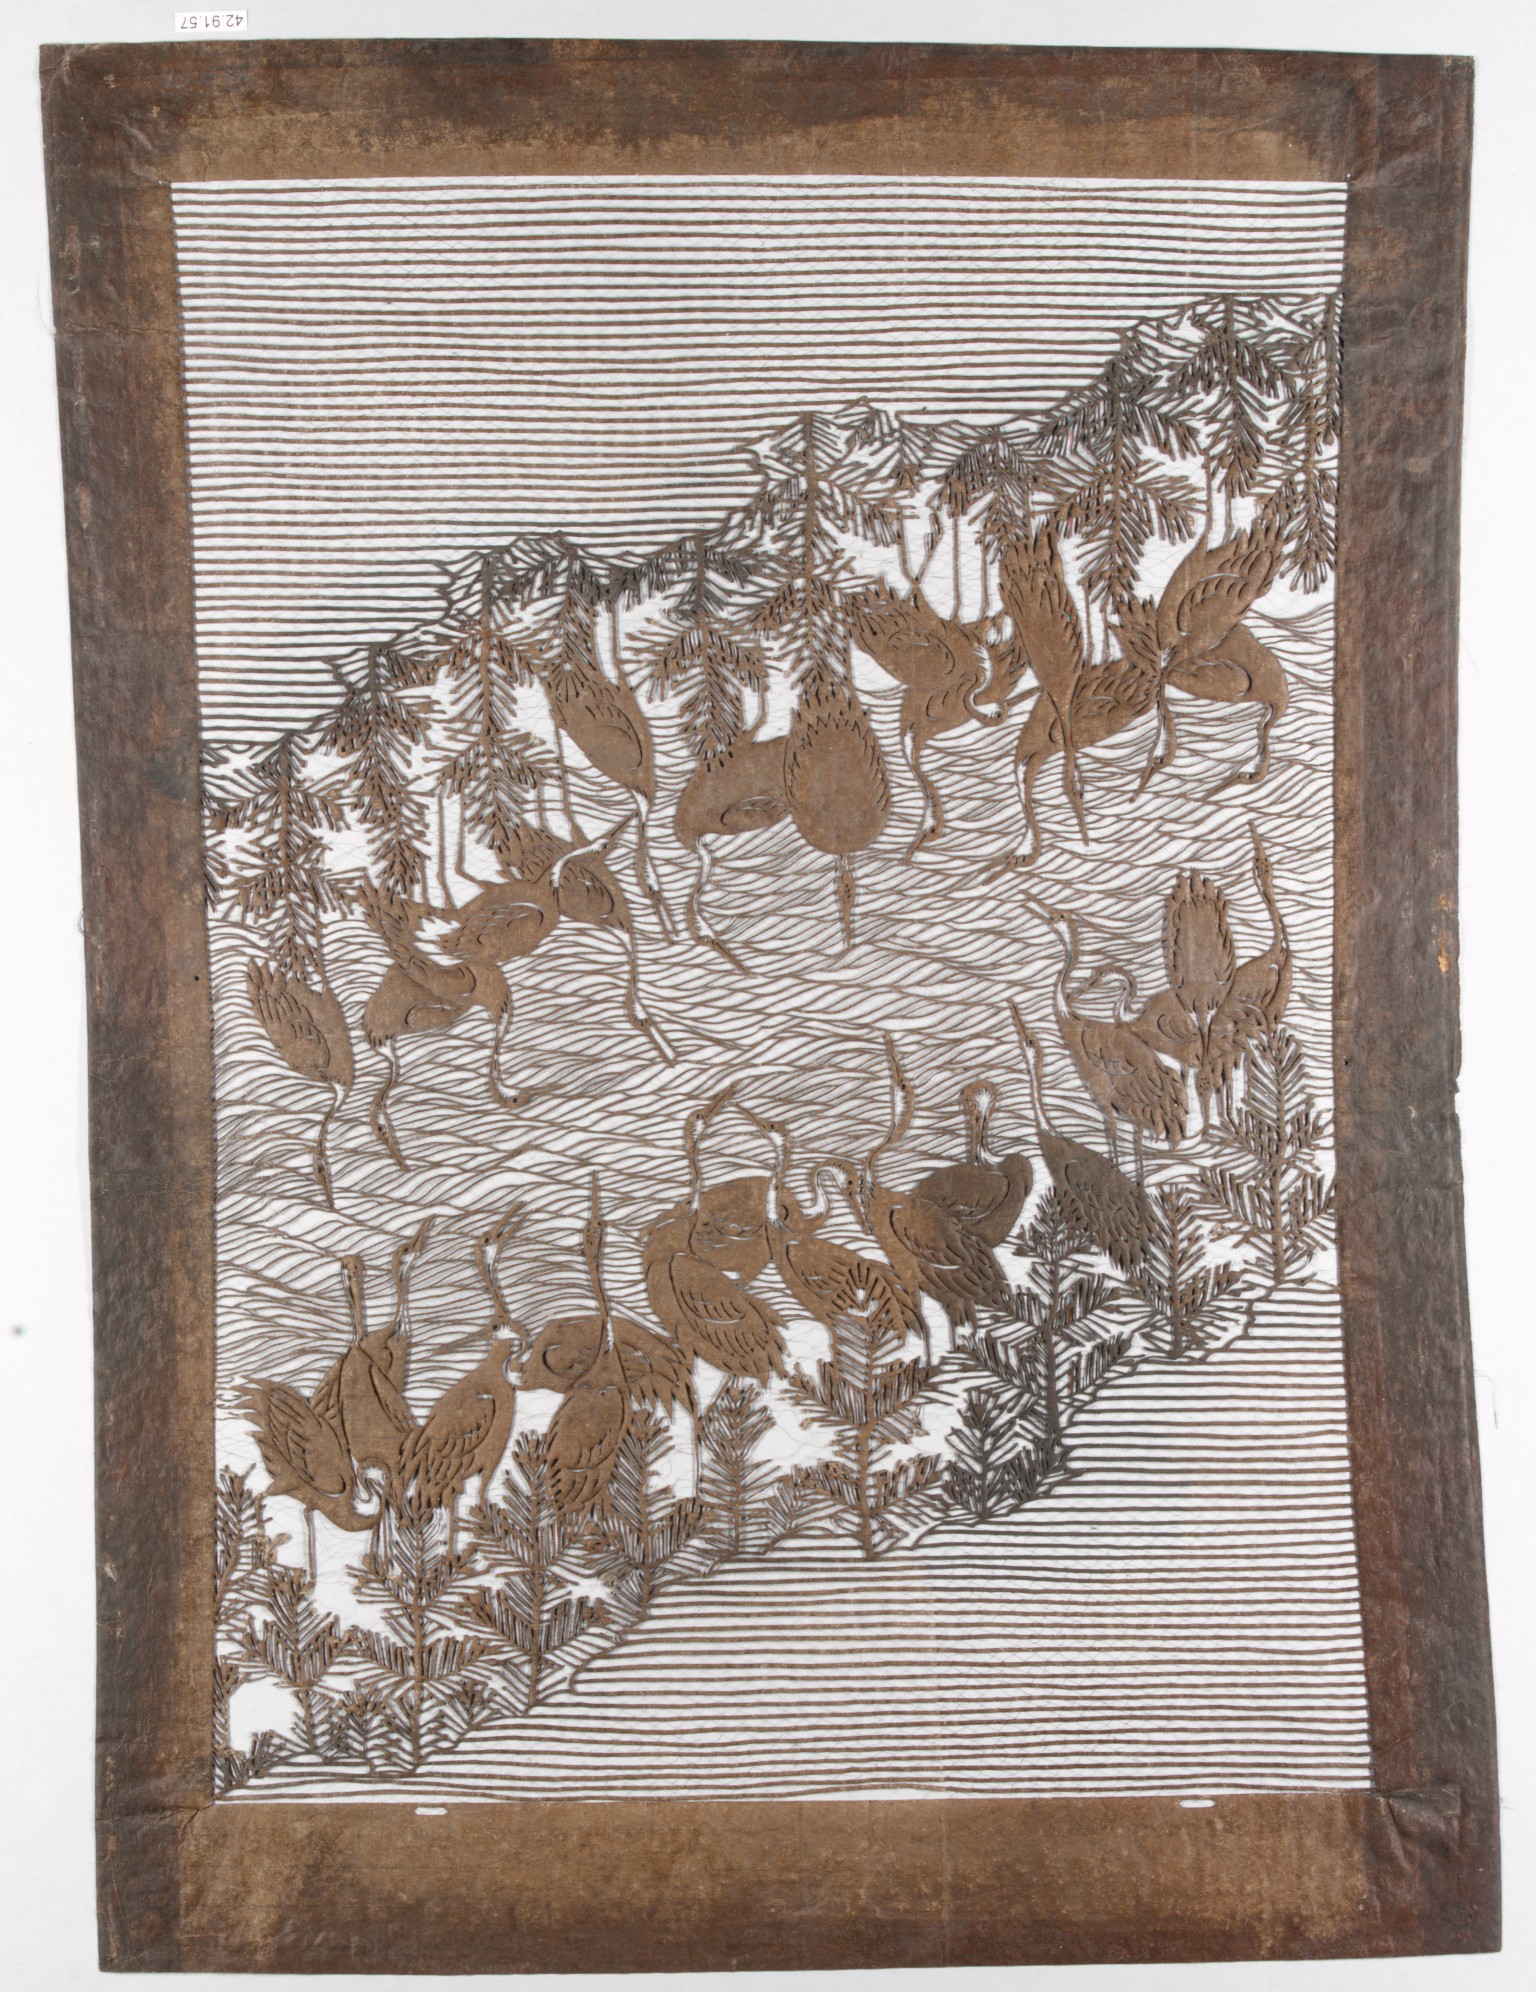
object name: stencil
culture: japanese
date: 1801-1900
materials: paper, silk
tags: cranes